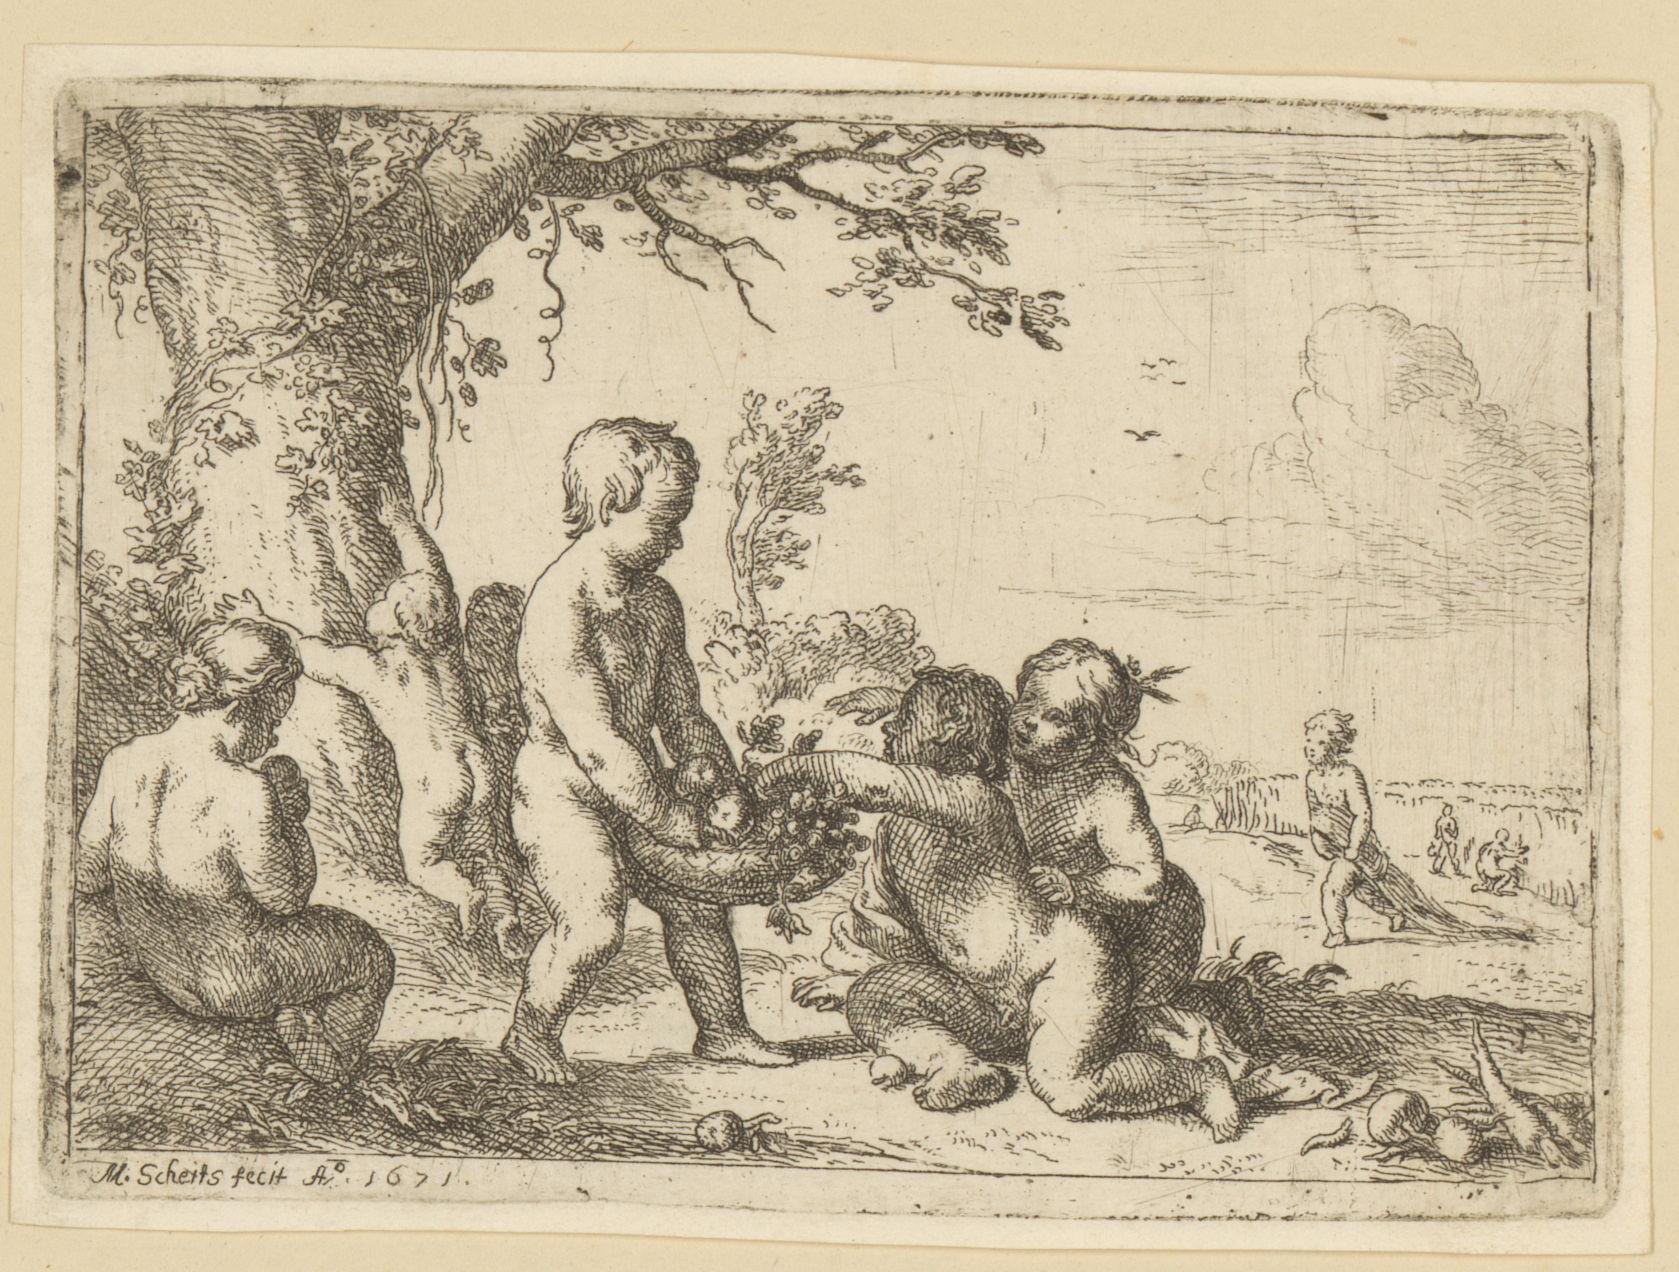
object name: print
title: Zomer: naakte kinderen plukken en eten fruit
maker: matthias scheits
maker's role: print maker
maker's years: 1625-1700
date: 1671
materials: paper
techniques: etching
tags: summer, 'aestas'; 'estate' (ripa), child, picking fruit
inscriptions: collector's mark: Lugt 240